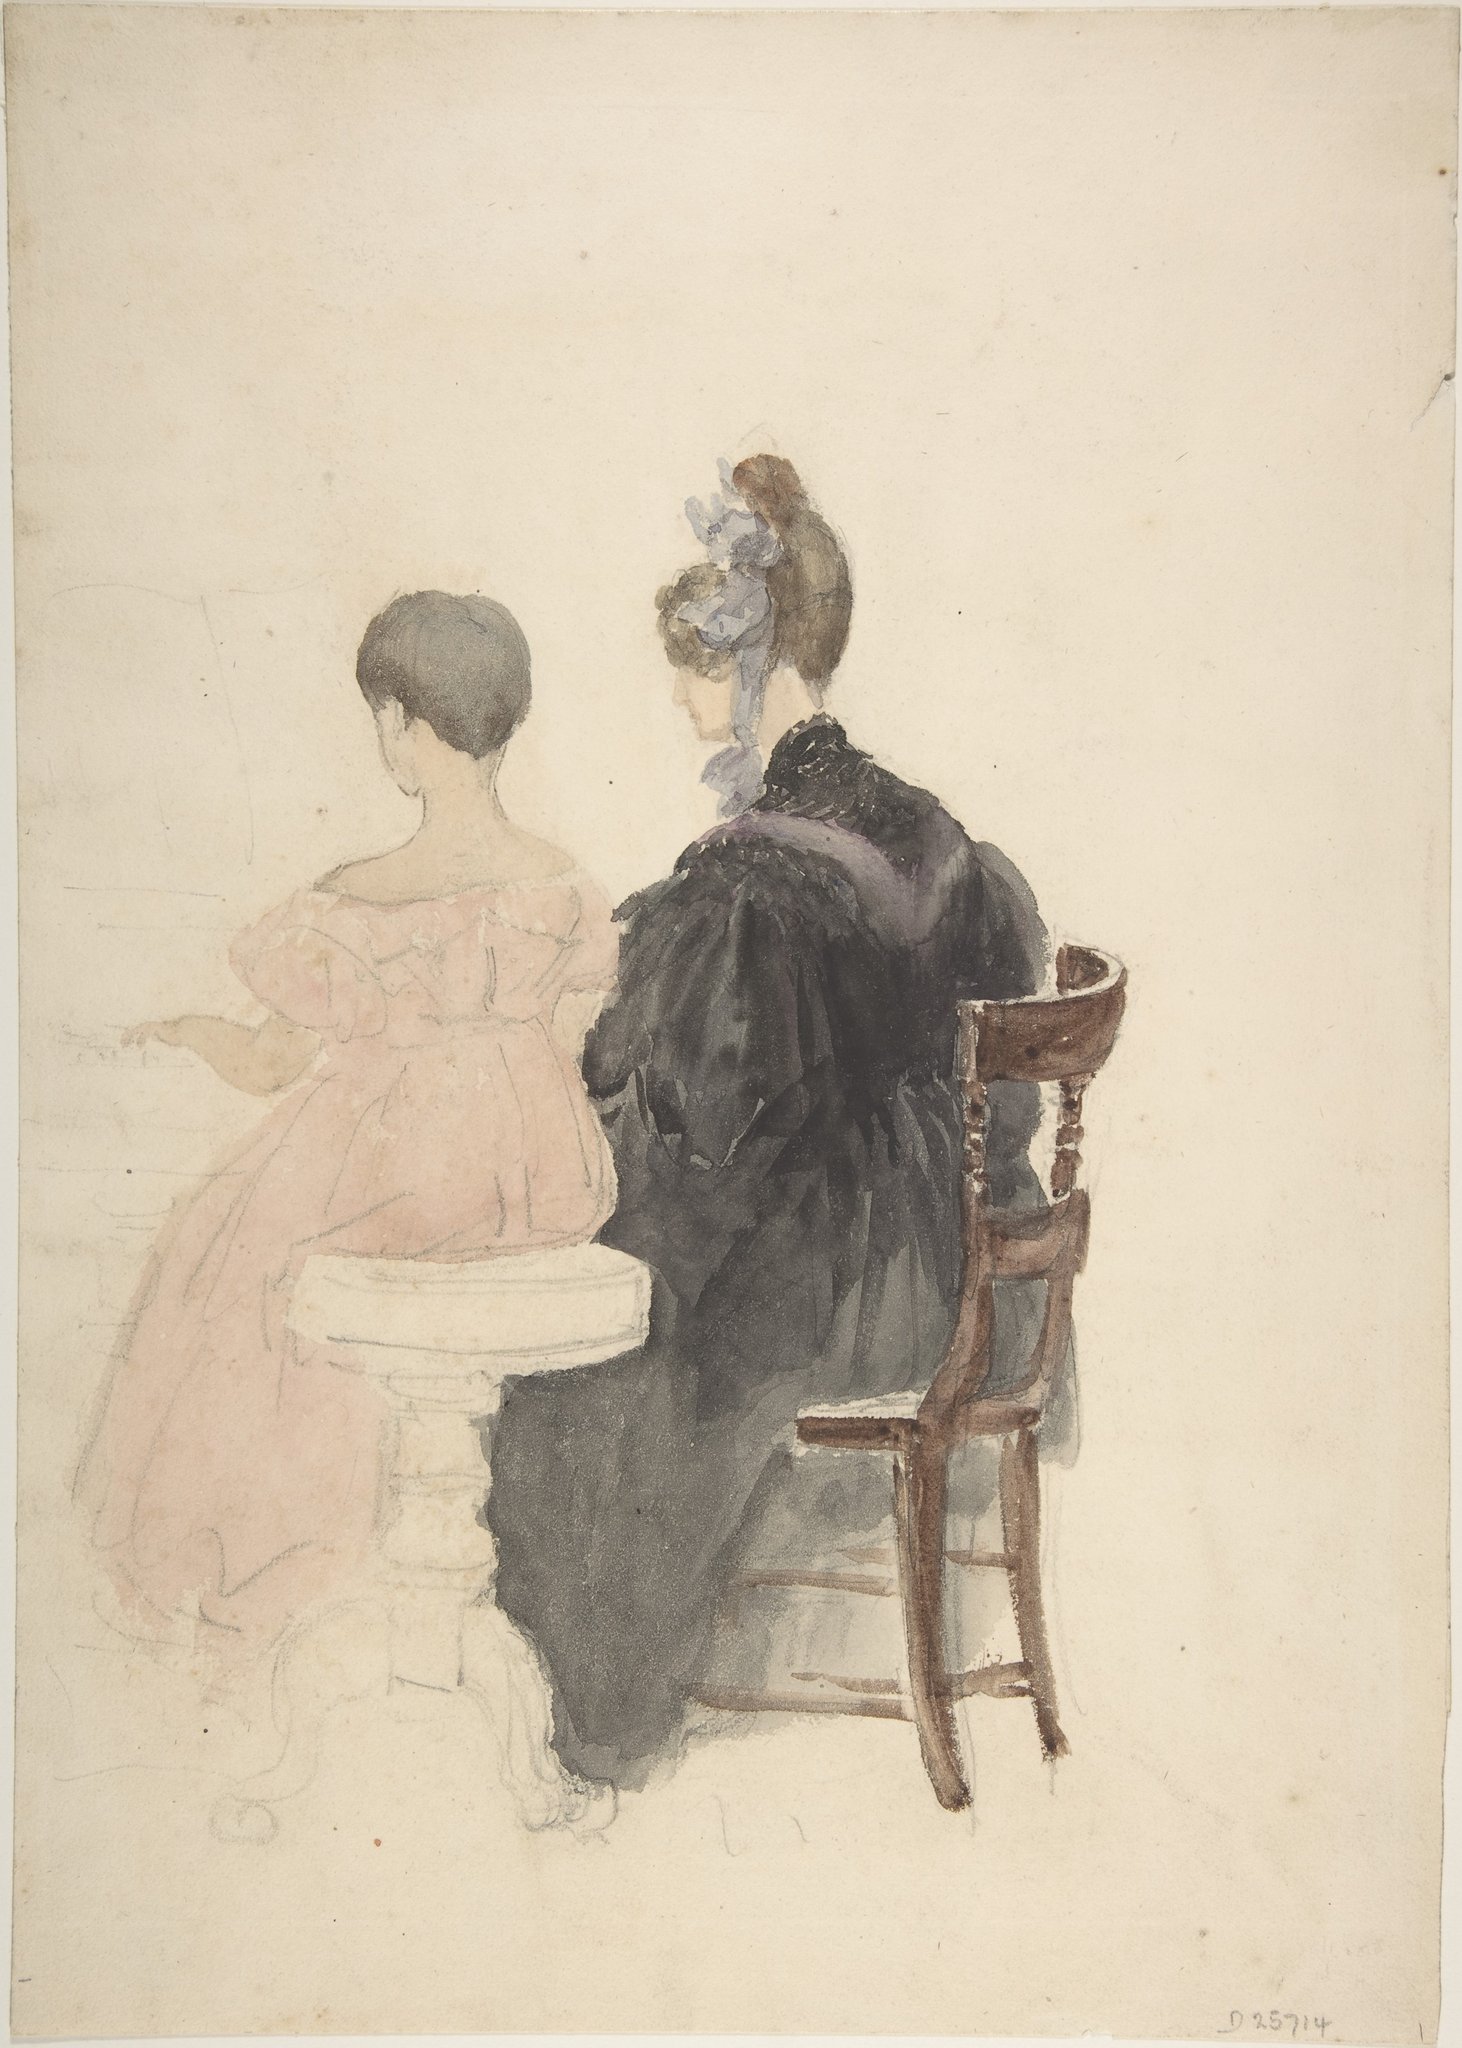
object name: drawing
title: A Piano Lesson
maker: david cox, the elder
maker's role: artist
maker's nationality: english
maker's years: 1783-1859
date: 1800-1859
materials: graphite, watercolor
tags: girls,women,pianos